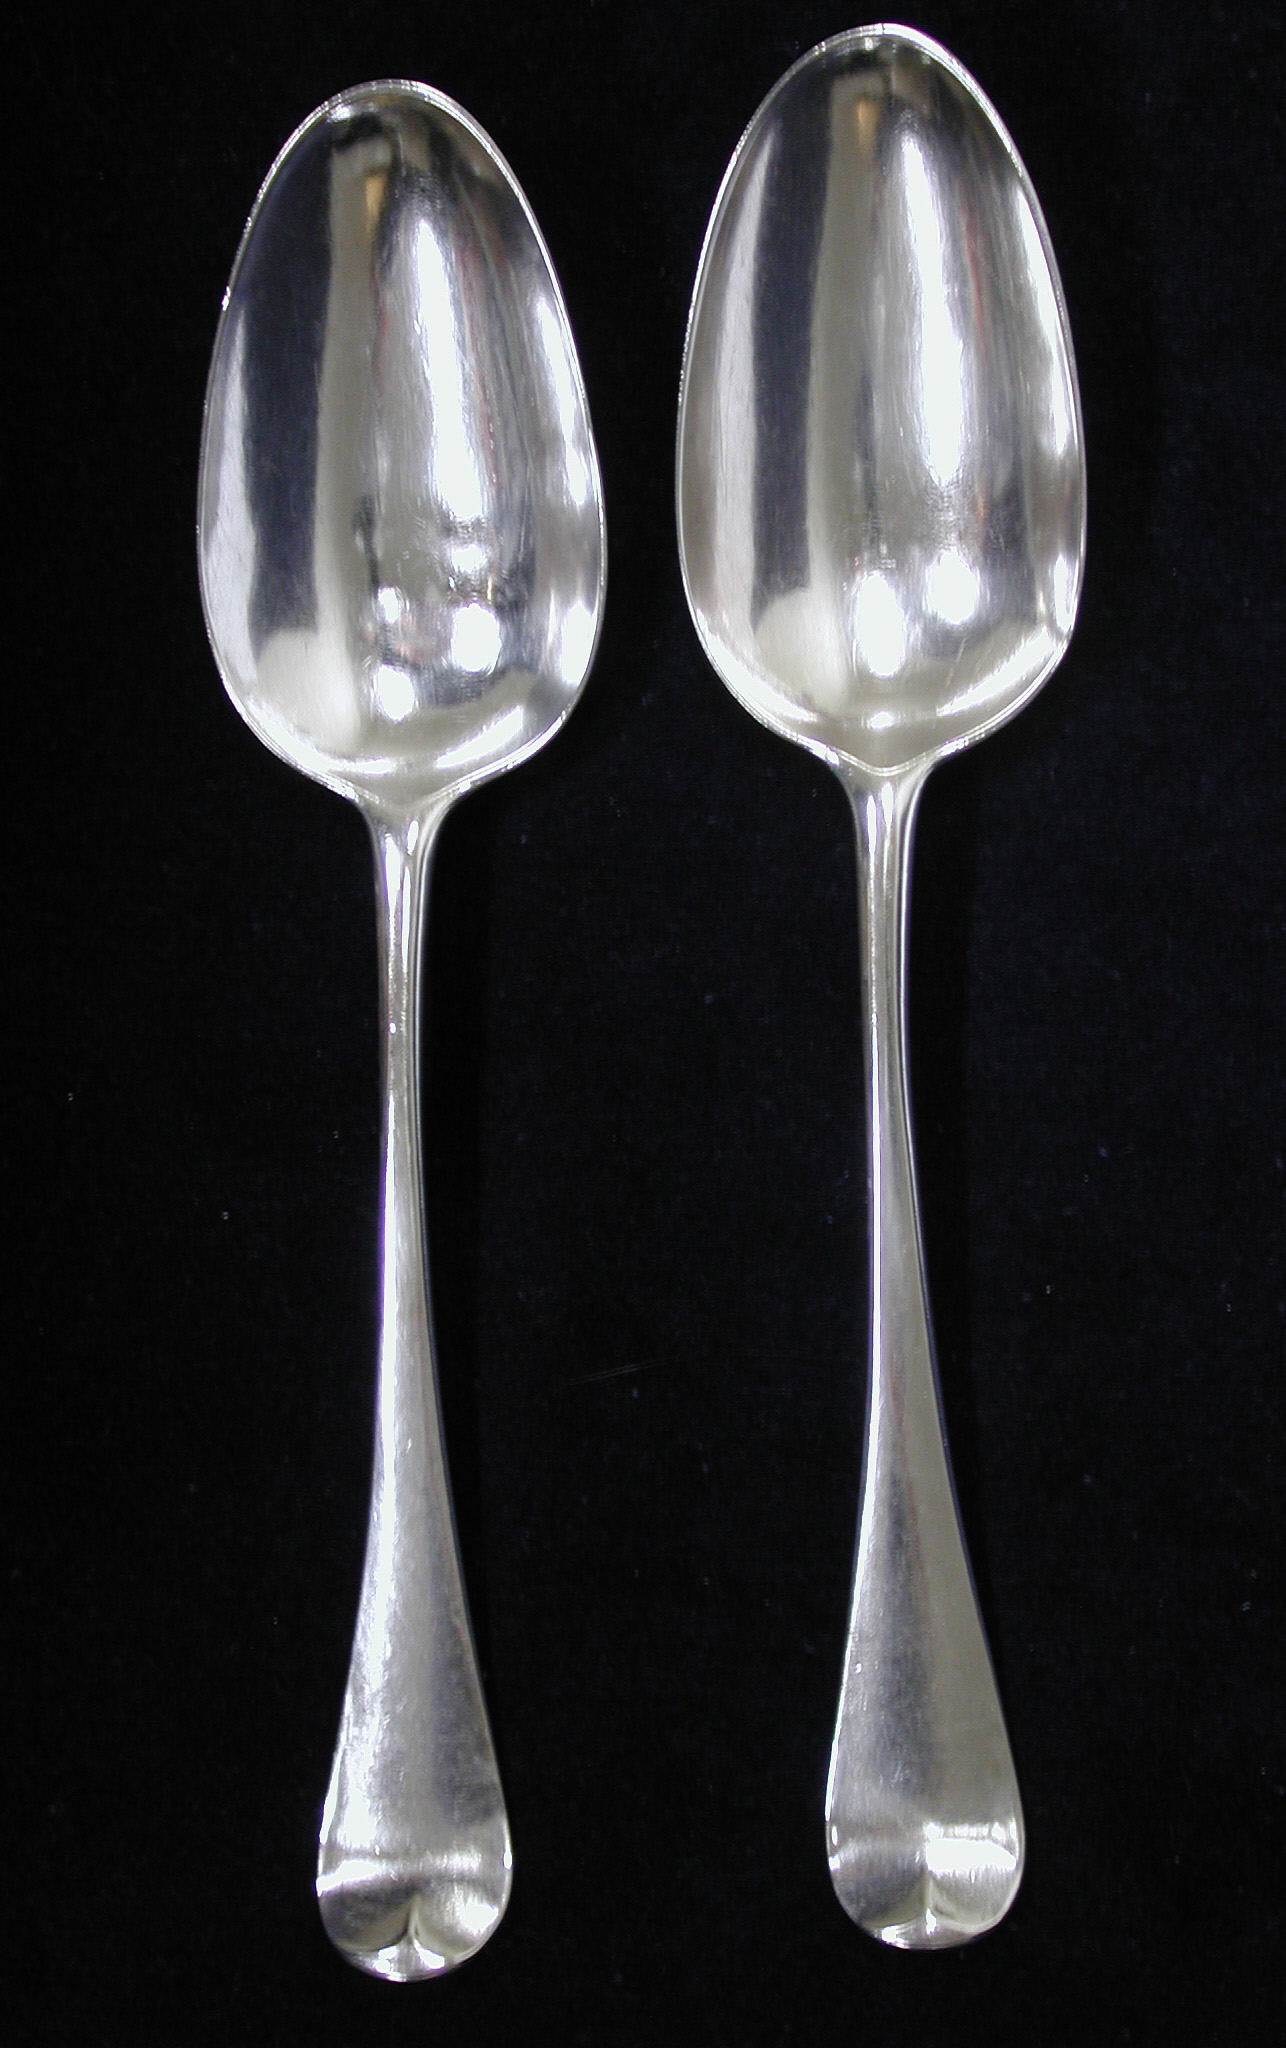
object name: spoon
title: Two spoons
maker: w. t., london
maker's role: maker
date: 1762-1763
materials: silver